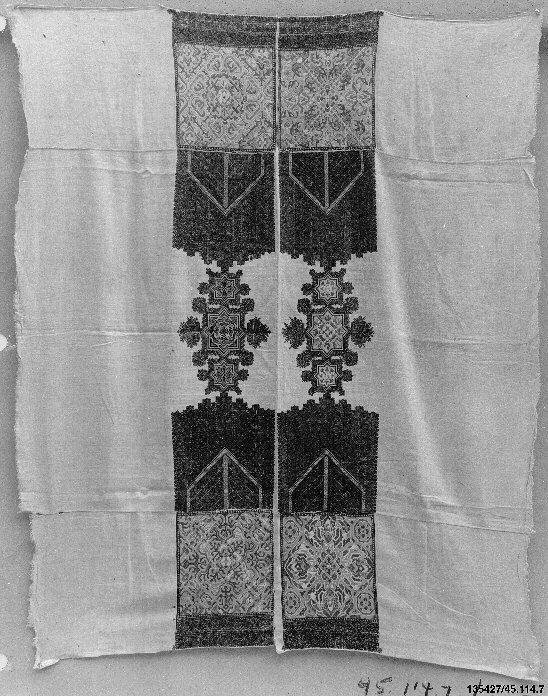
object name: hanging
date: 1701-1800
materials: linen, silk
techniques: embroidery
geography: morocco